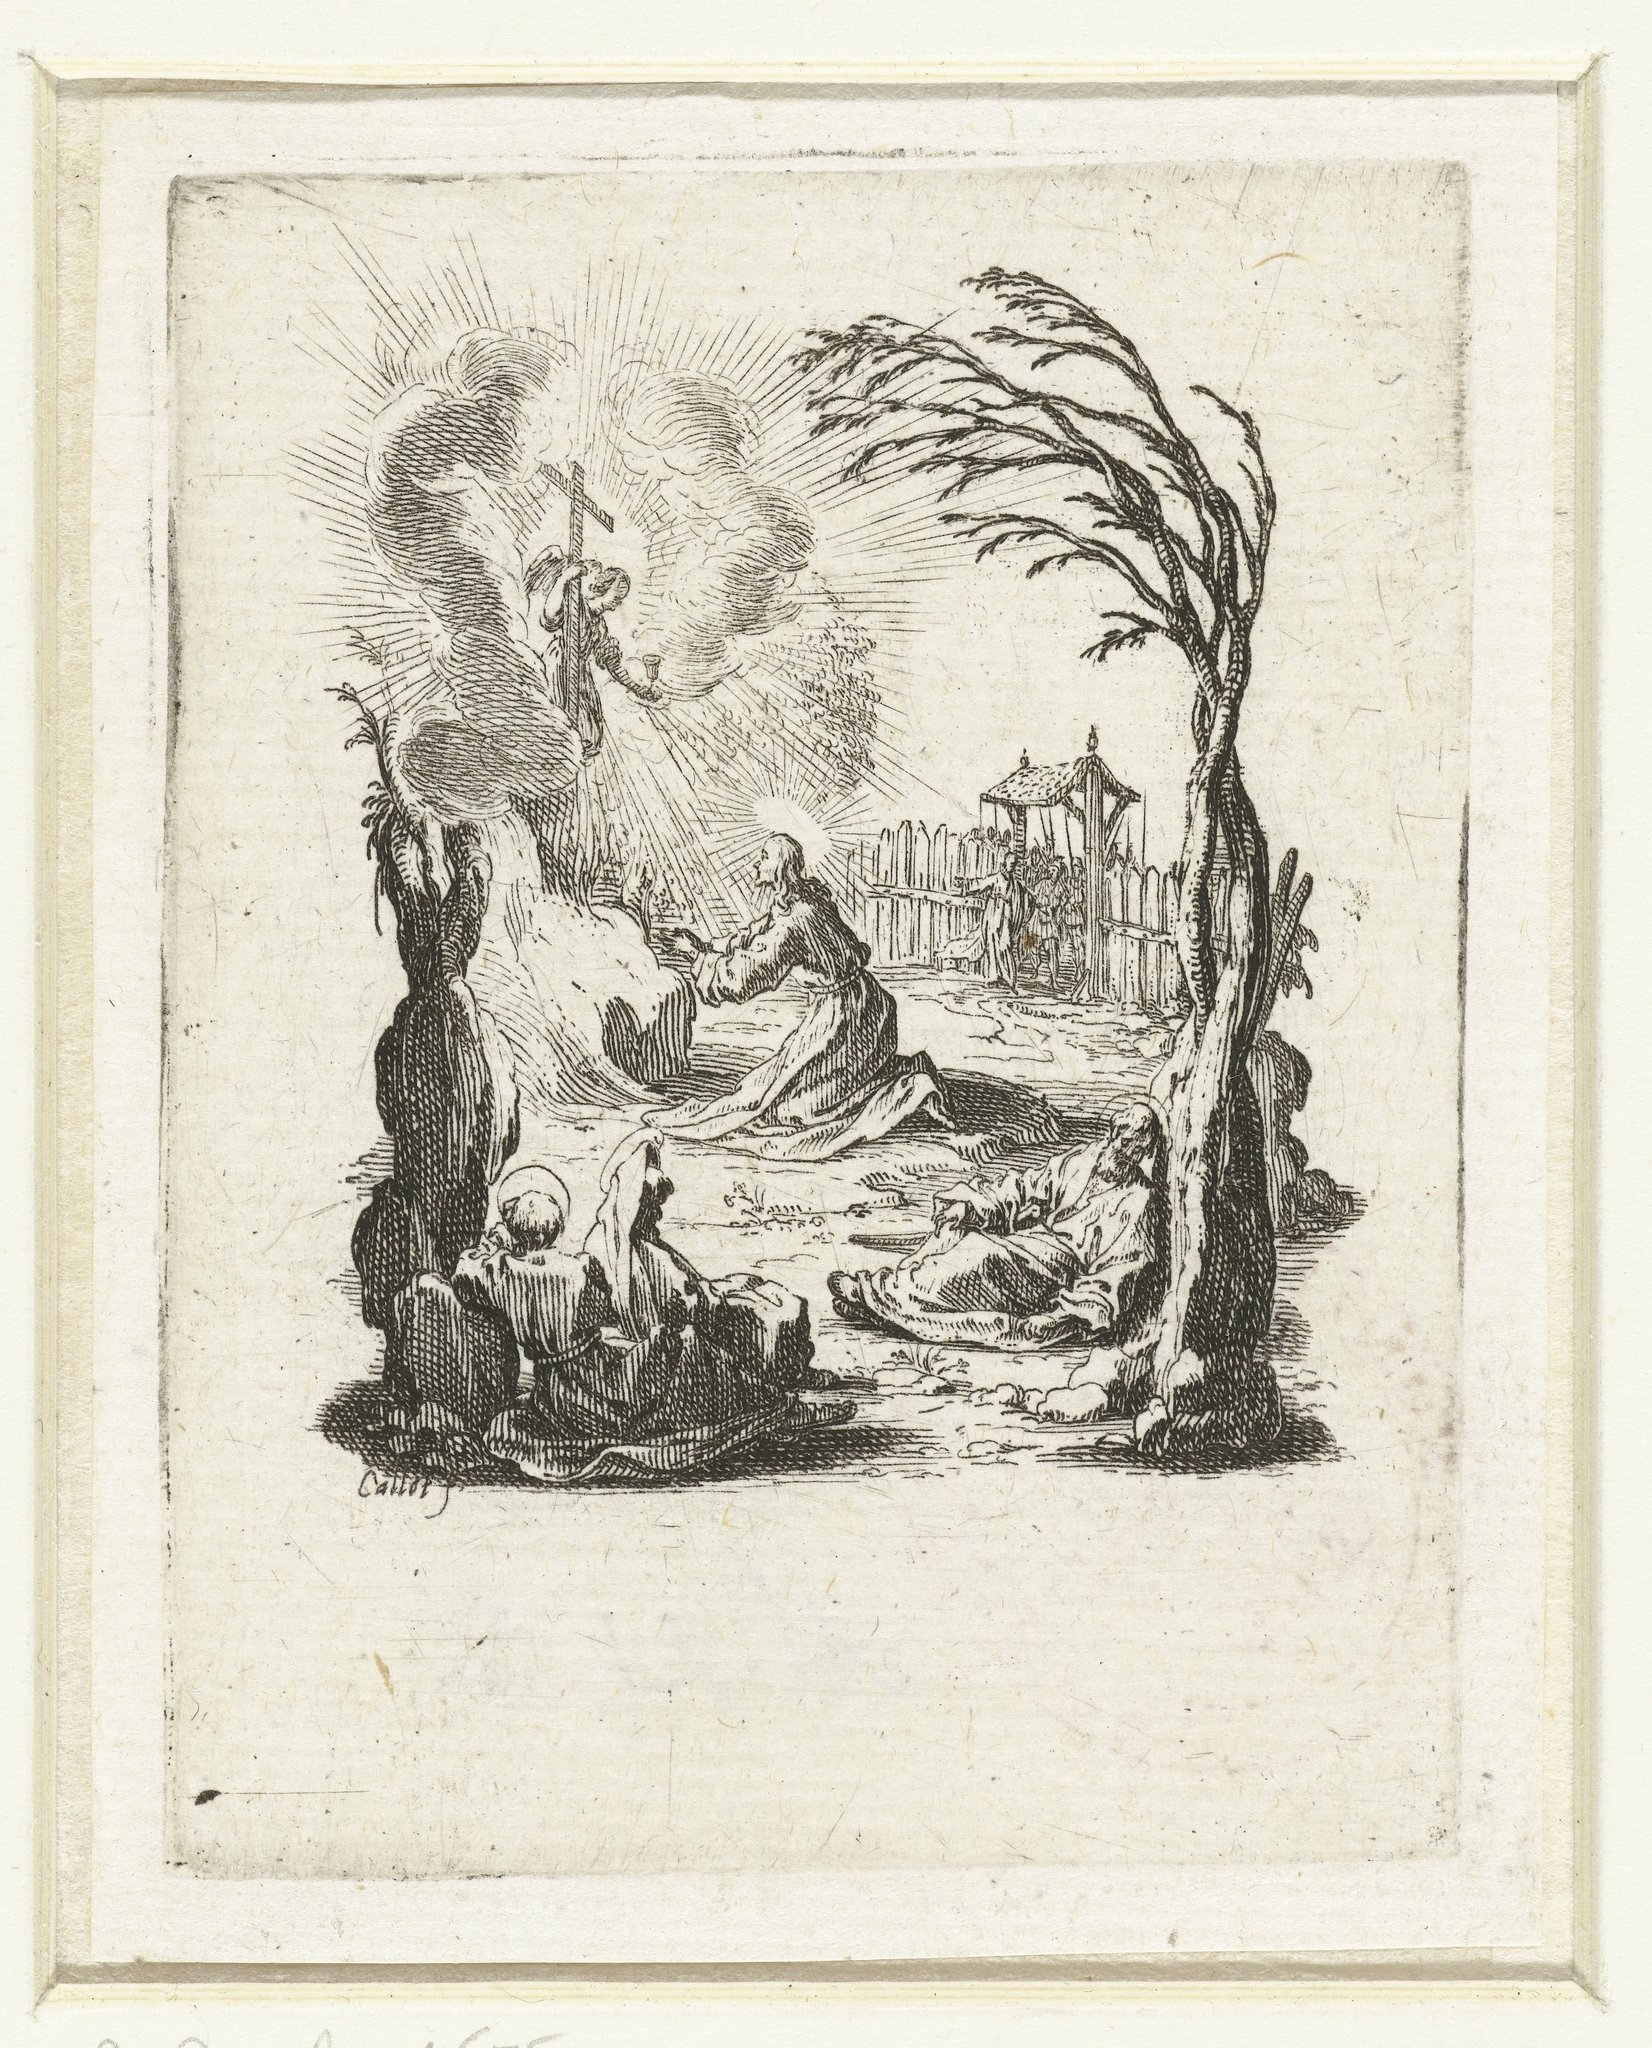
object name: print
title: De kleine Passie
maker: jacques callot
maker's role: draughtsman, print maker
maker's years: 1592-1635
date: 1624-1625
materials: paper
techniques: etching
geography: nancy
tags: agony of christ; three (or eleven) apostles sleeping, agony of christ: to comfort him one or more angels appear to christ with chalice and/or cross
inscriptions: collector's mark: Lugt 240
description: Christus bidt geknield voor een visioen van een kruis. Op de voorgrond drie van zijn discipelen, slapend. Rechts op de achtergrond komt met Judas met enkele gewapende mannen aanlopen. Deze prent is onderdeel van de prentserie 'De kleine Passie', bestaande uit 12 scènes uit het Lijdensverhaal.